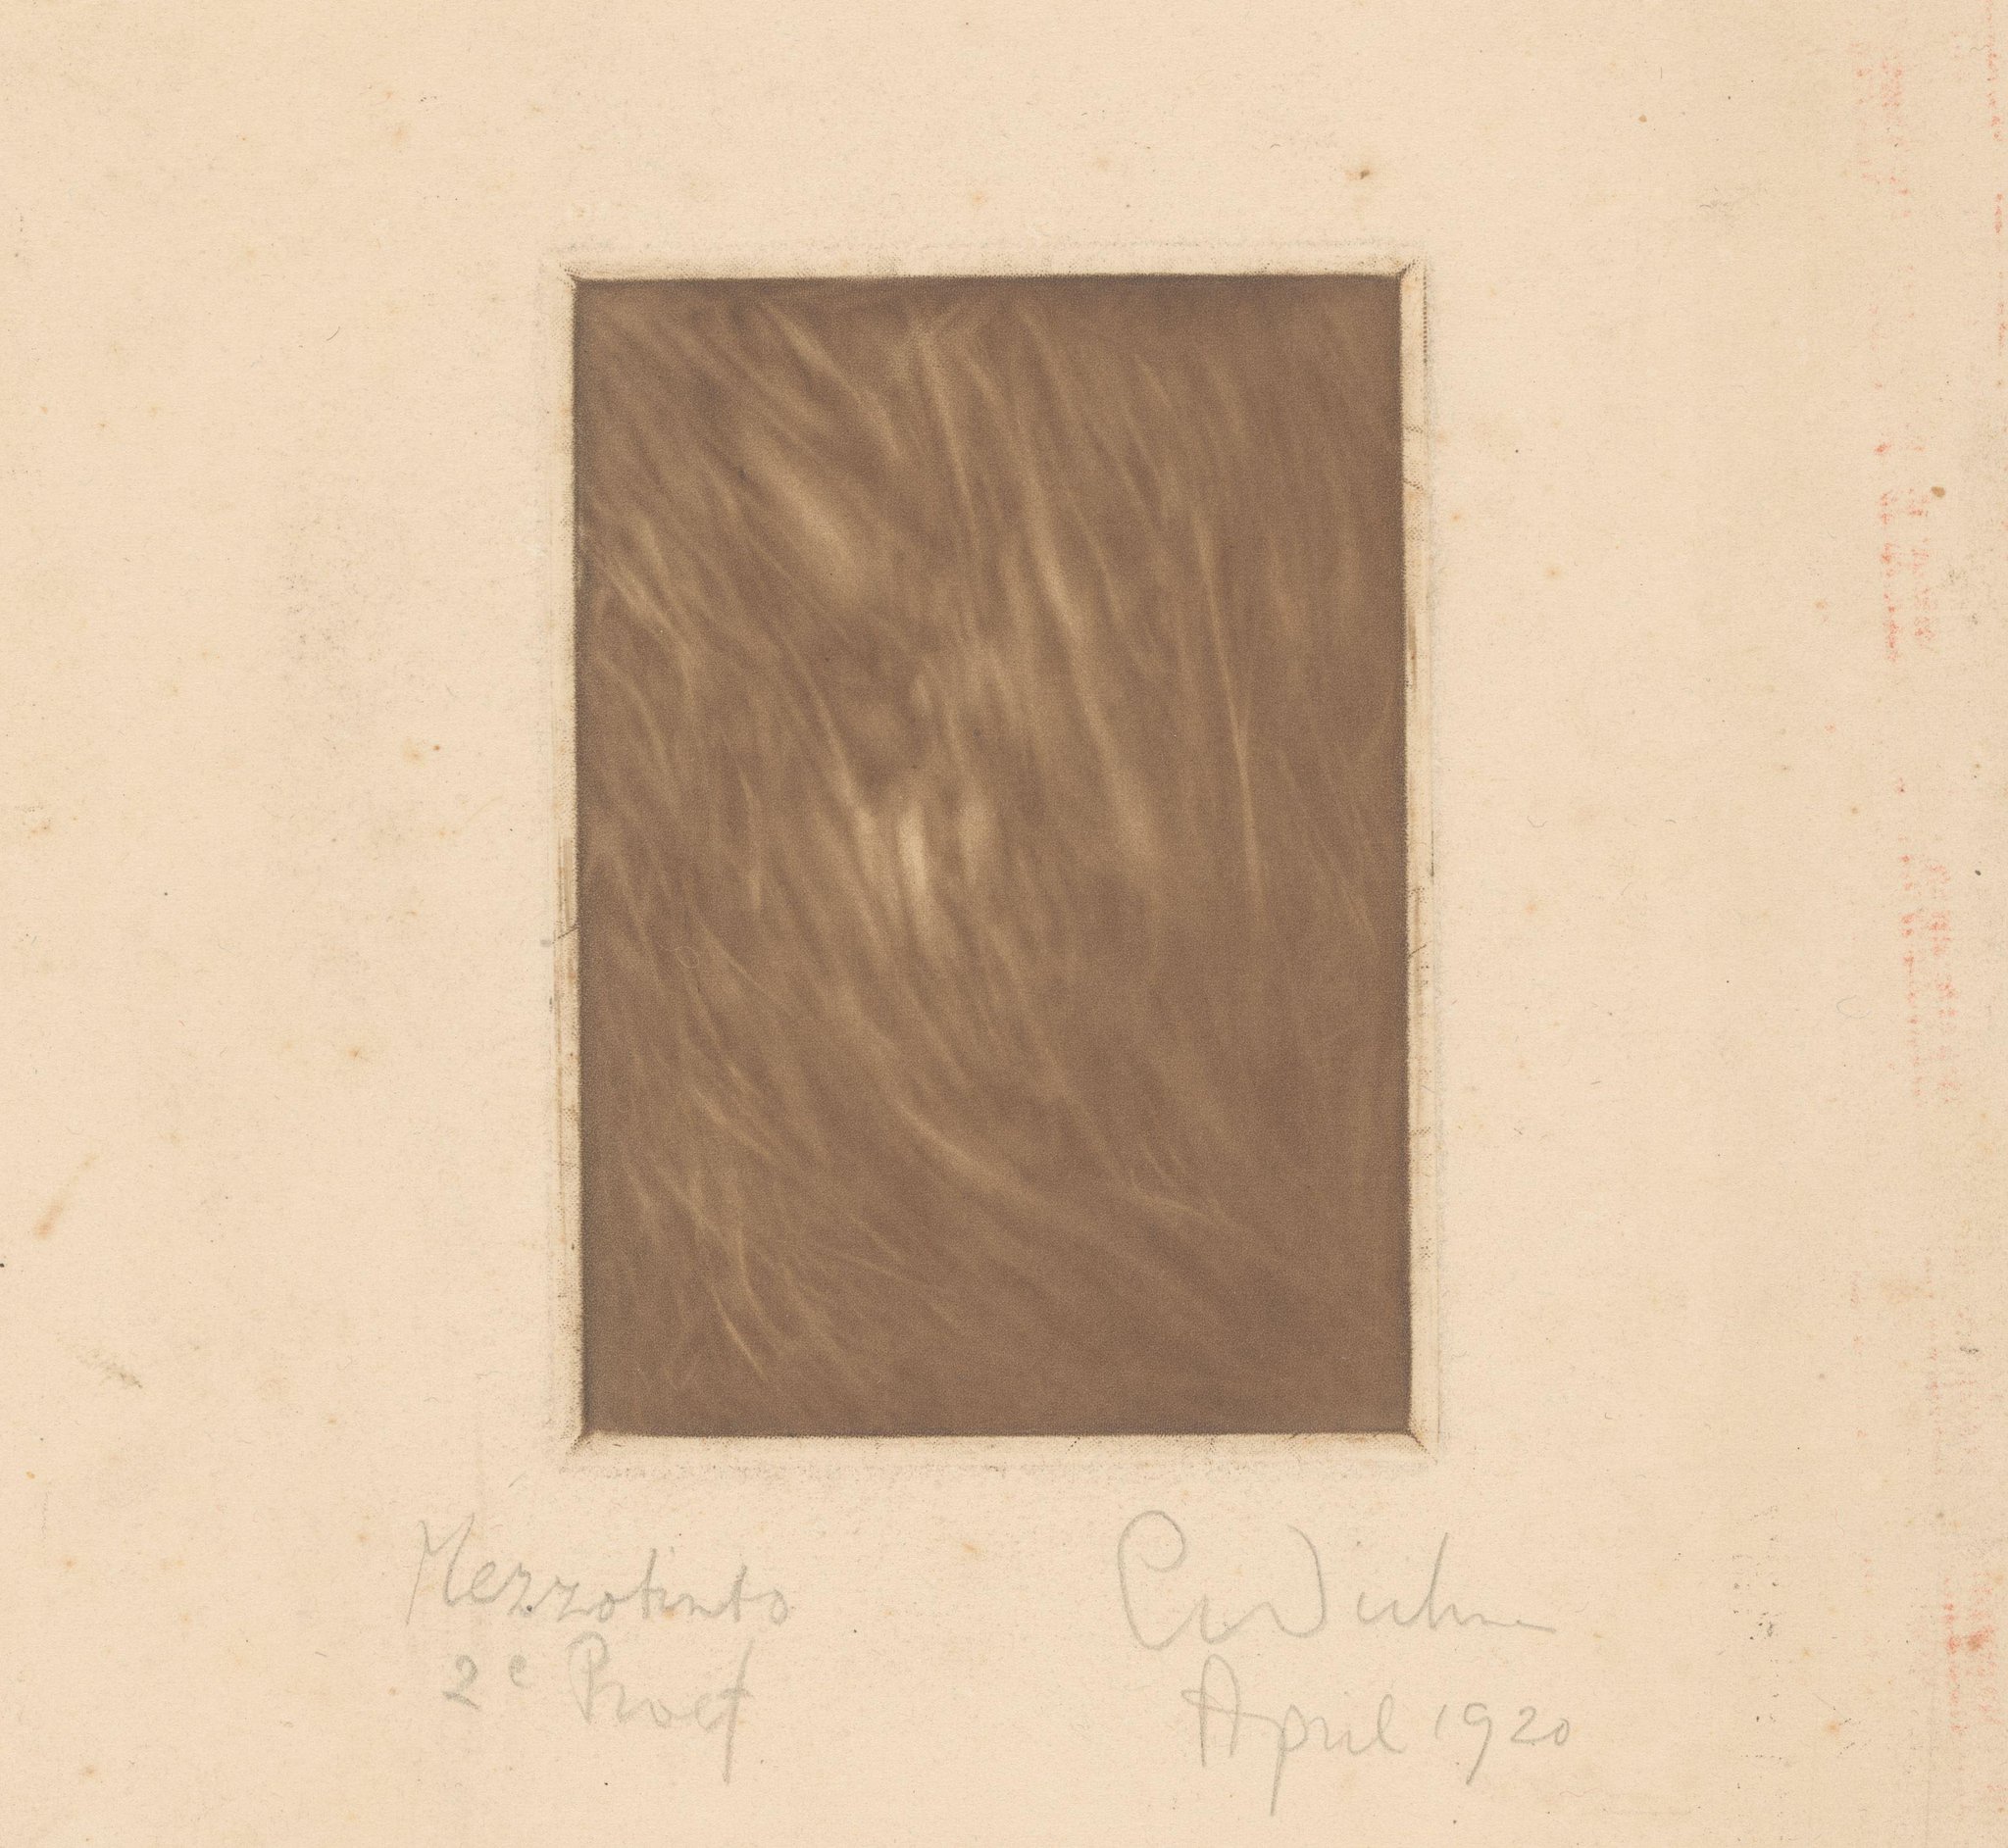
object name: print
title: Abstracte compositie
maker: erich wichmann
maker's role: print maker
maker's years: 1890-1929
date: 1904-1920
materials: paper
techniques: mezzotint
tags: abstract, non-representational art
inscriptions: collector's mark: Lugt 2228